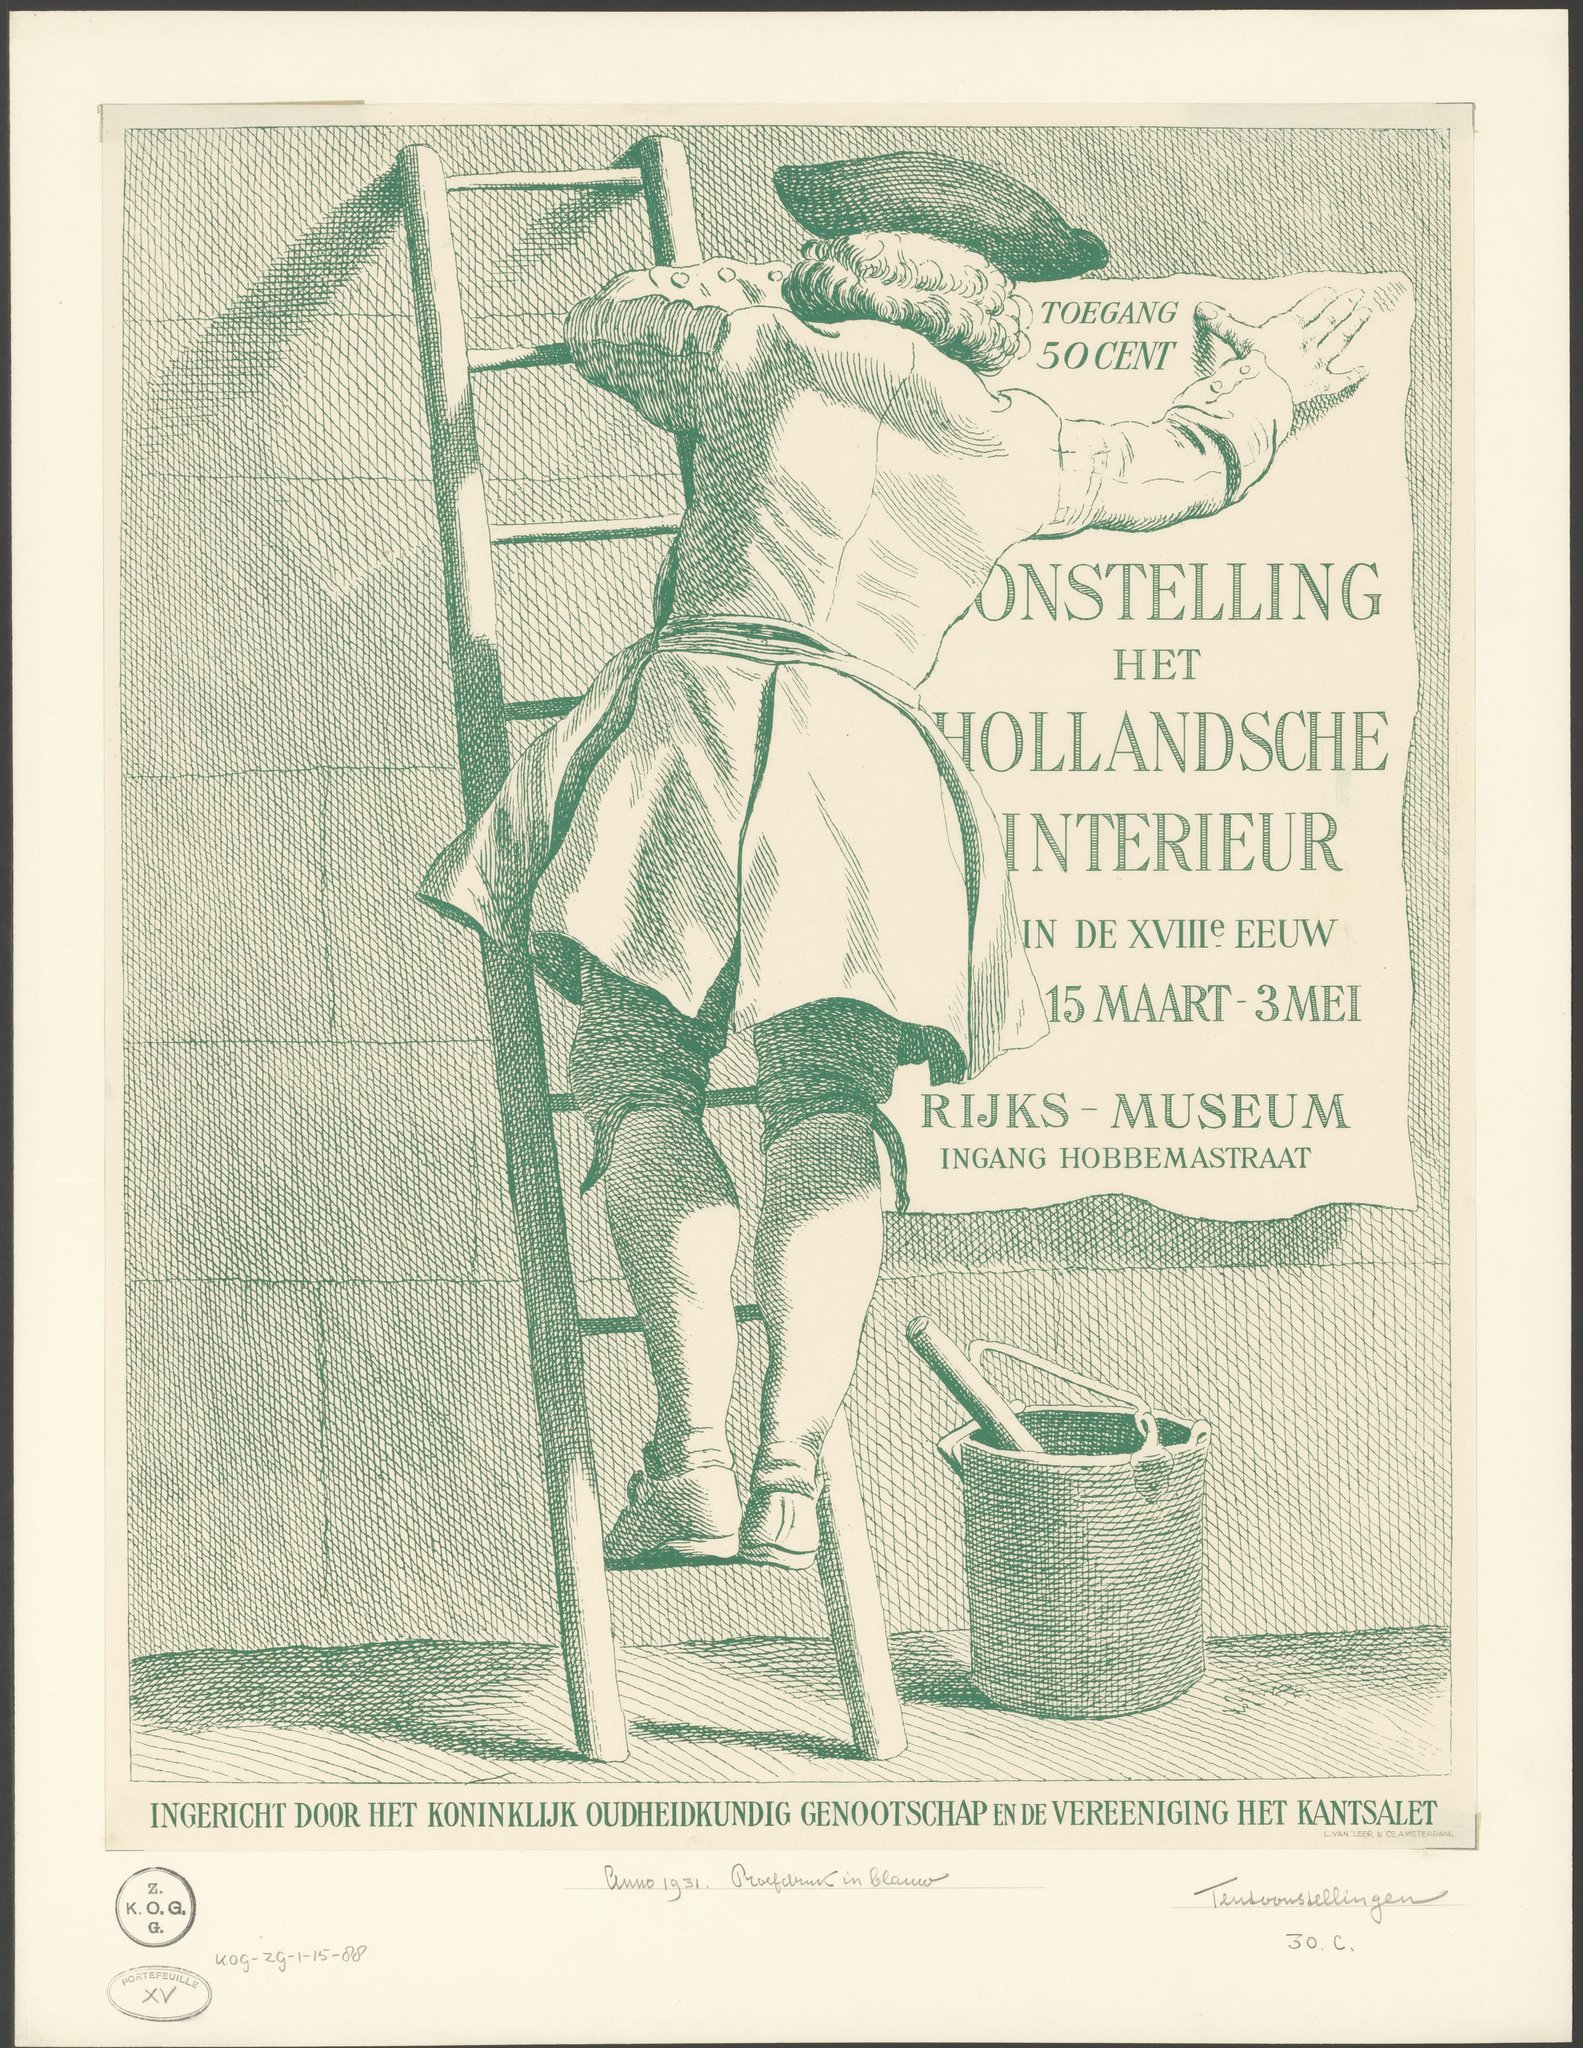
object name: poster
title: Tentoonstelling het Hollandsche Interieur, 1931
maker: Anonymous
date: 1931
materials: paper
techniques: printing block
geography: amsterdam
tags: lace, collection, exhibition, show, amsterdam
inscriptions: collector's mark: Lugt 1641, stamp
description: Affiche voor de tentoonstelling over het Hollandse Interieur van de achttiende eeuw in het Rijksmuseum. Gehouden tussen 15 maart en 3 mei in 1931. De tentoonstelling is ingericht door het Koninklijke Oudheidkundig Genootschap en de Vereeniging het Kantsalet. Onderwerpsrubrieken binnen de Atlas Zeden en Gewoonten: Handel, nijverheid en verkeer, Tentoonstellingen.